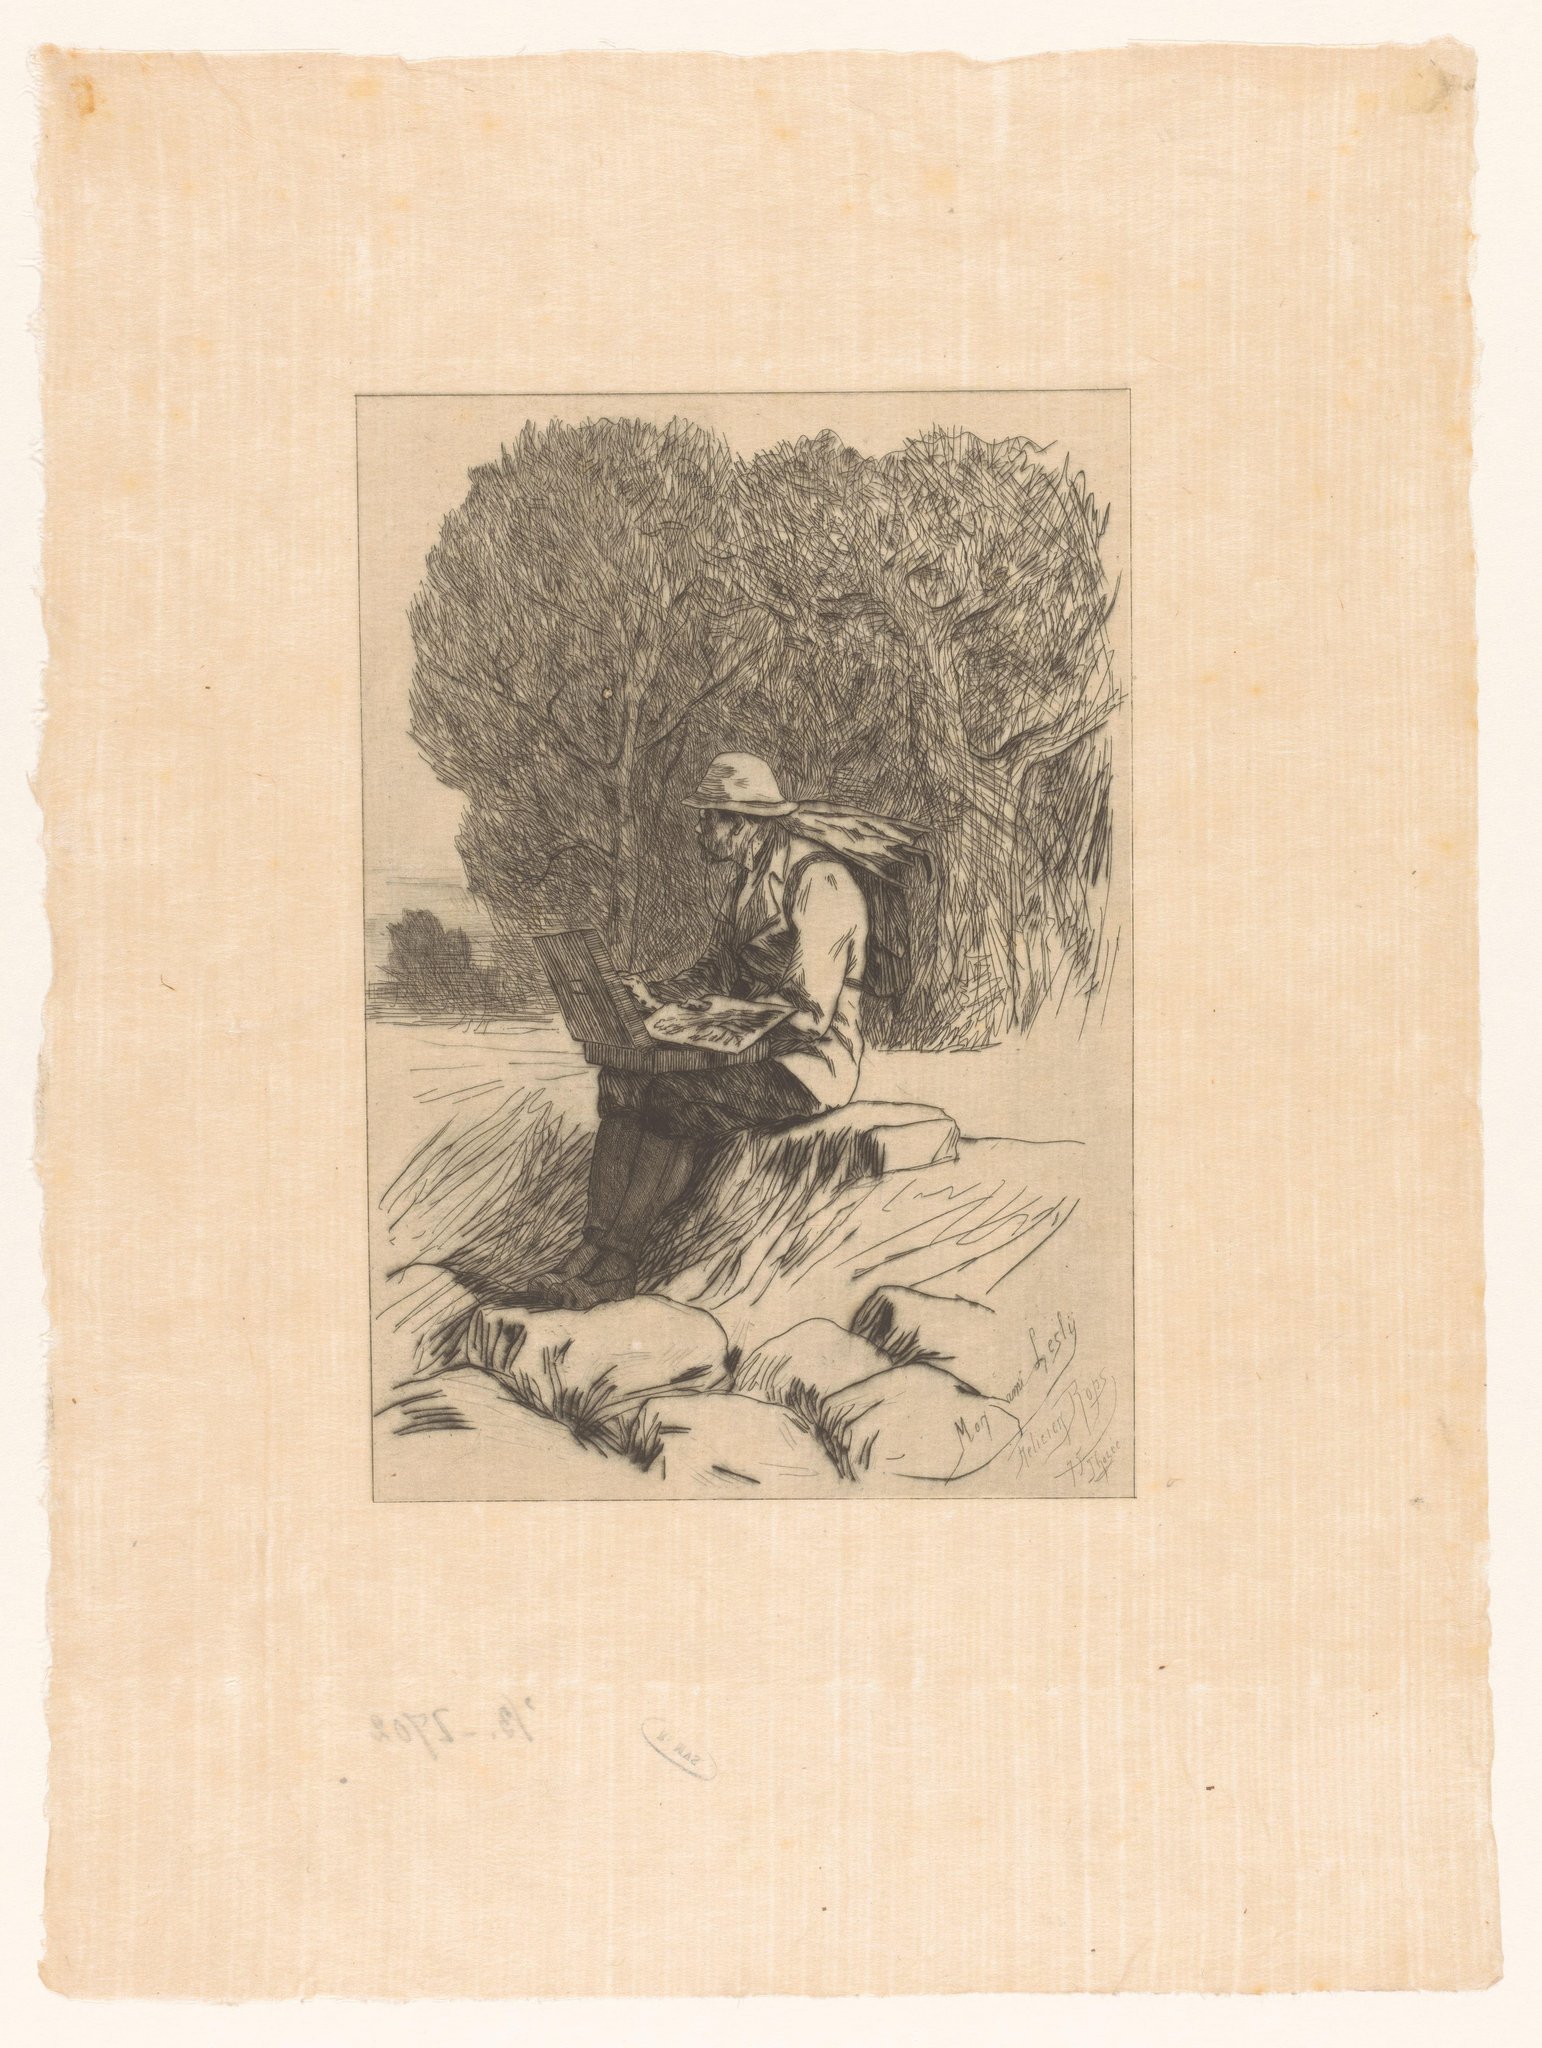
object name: print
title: Kunstenaar aan het werk in het veld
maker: félicien rops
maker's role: draughtsman, print maker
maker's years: 1833-1898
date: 1875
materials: paper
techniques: drypoint, etching, intaglio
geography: namur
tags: painter at work, in his studio - cc - out of doors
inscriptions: collector's mark: Lugt 2228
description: De latere staat van deze prent is gebruikt in: Rops, Félicien (red.), Album d'eaux-fortes originales et inédites. Brussel: Felix Callewaert père, 1875.